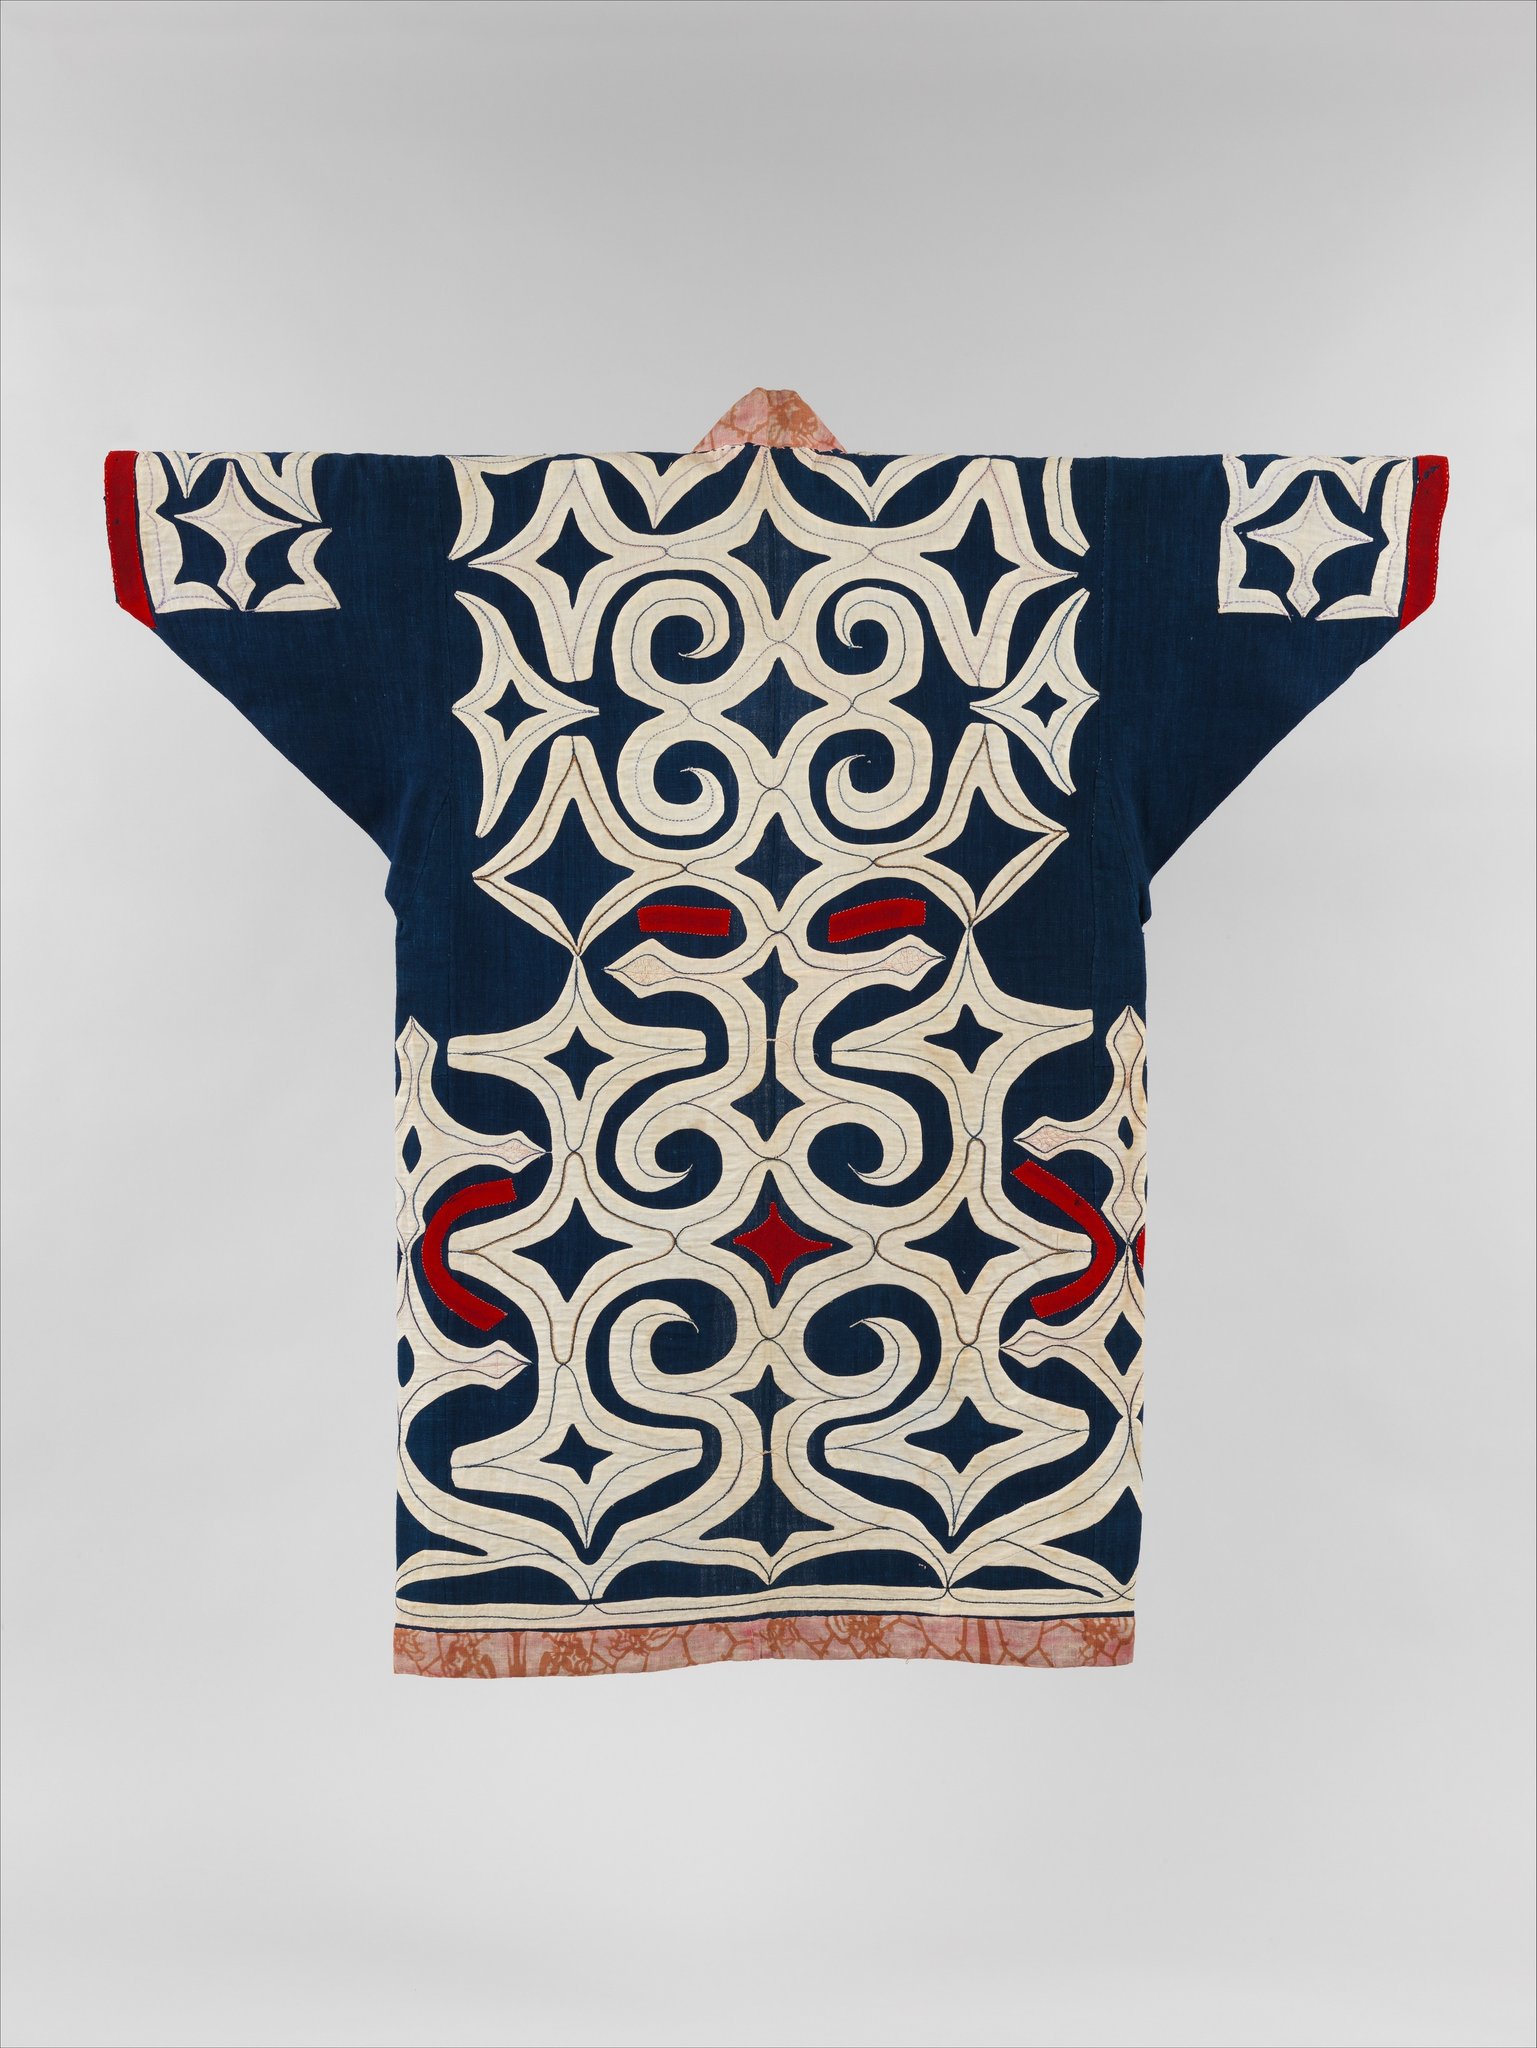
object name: ainu robe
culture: japanese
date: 1868-1912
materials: cotton, wool